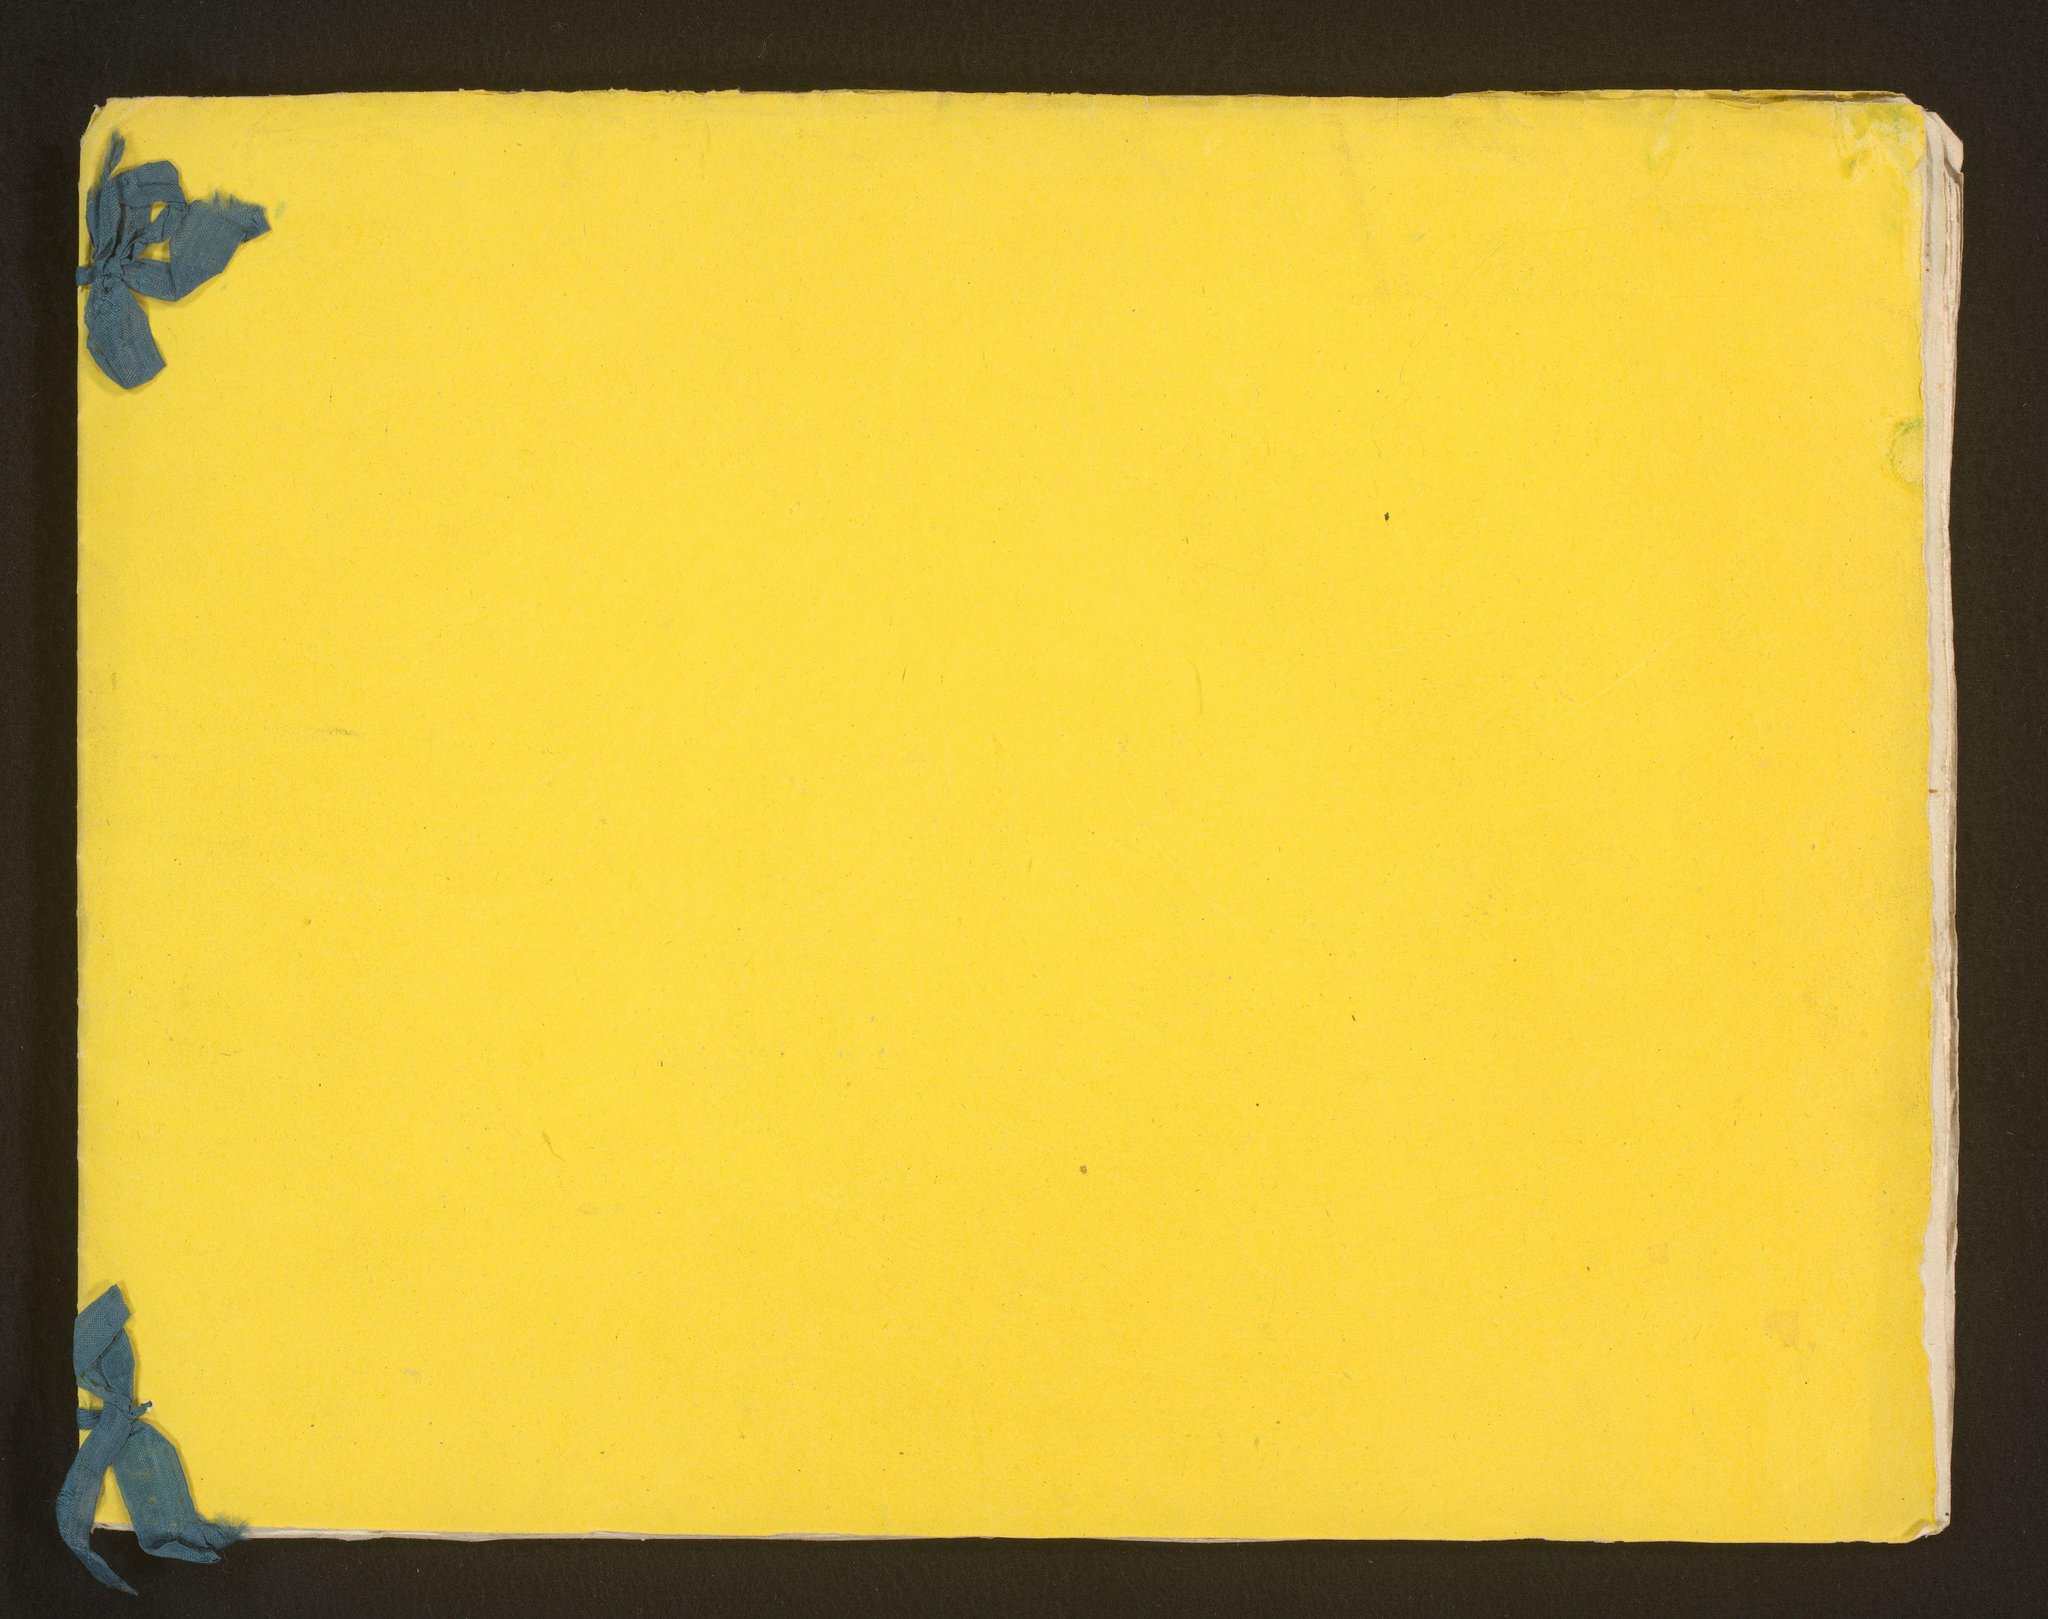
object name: prentrecueil, prentenalbum, prentalbum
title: Album met vier tekenvoorbeelden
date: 1800-1825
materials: paper, silk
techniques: bookbinding, printmaking, engraving, etching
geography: paris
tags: well, landscapes, quarry, windmill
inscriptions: collector's mark: Lugt 2228, collector's mark: Lugt 2760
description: Album met vier prenten op vier bladen. De ongenummerde prenten met figuren zijn bedoeld als tekenvoorbeeld voor de jeugd. Prenten behoren tot de serie 'Ier. cahier petites etudes'.